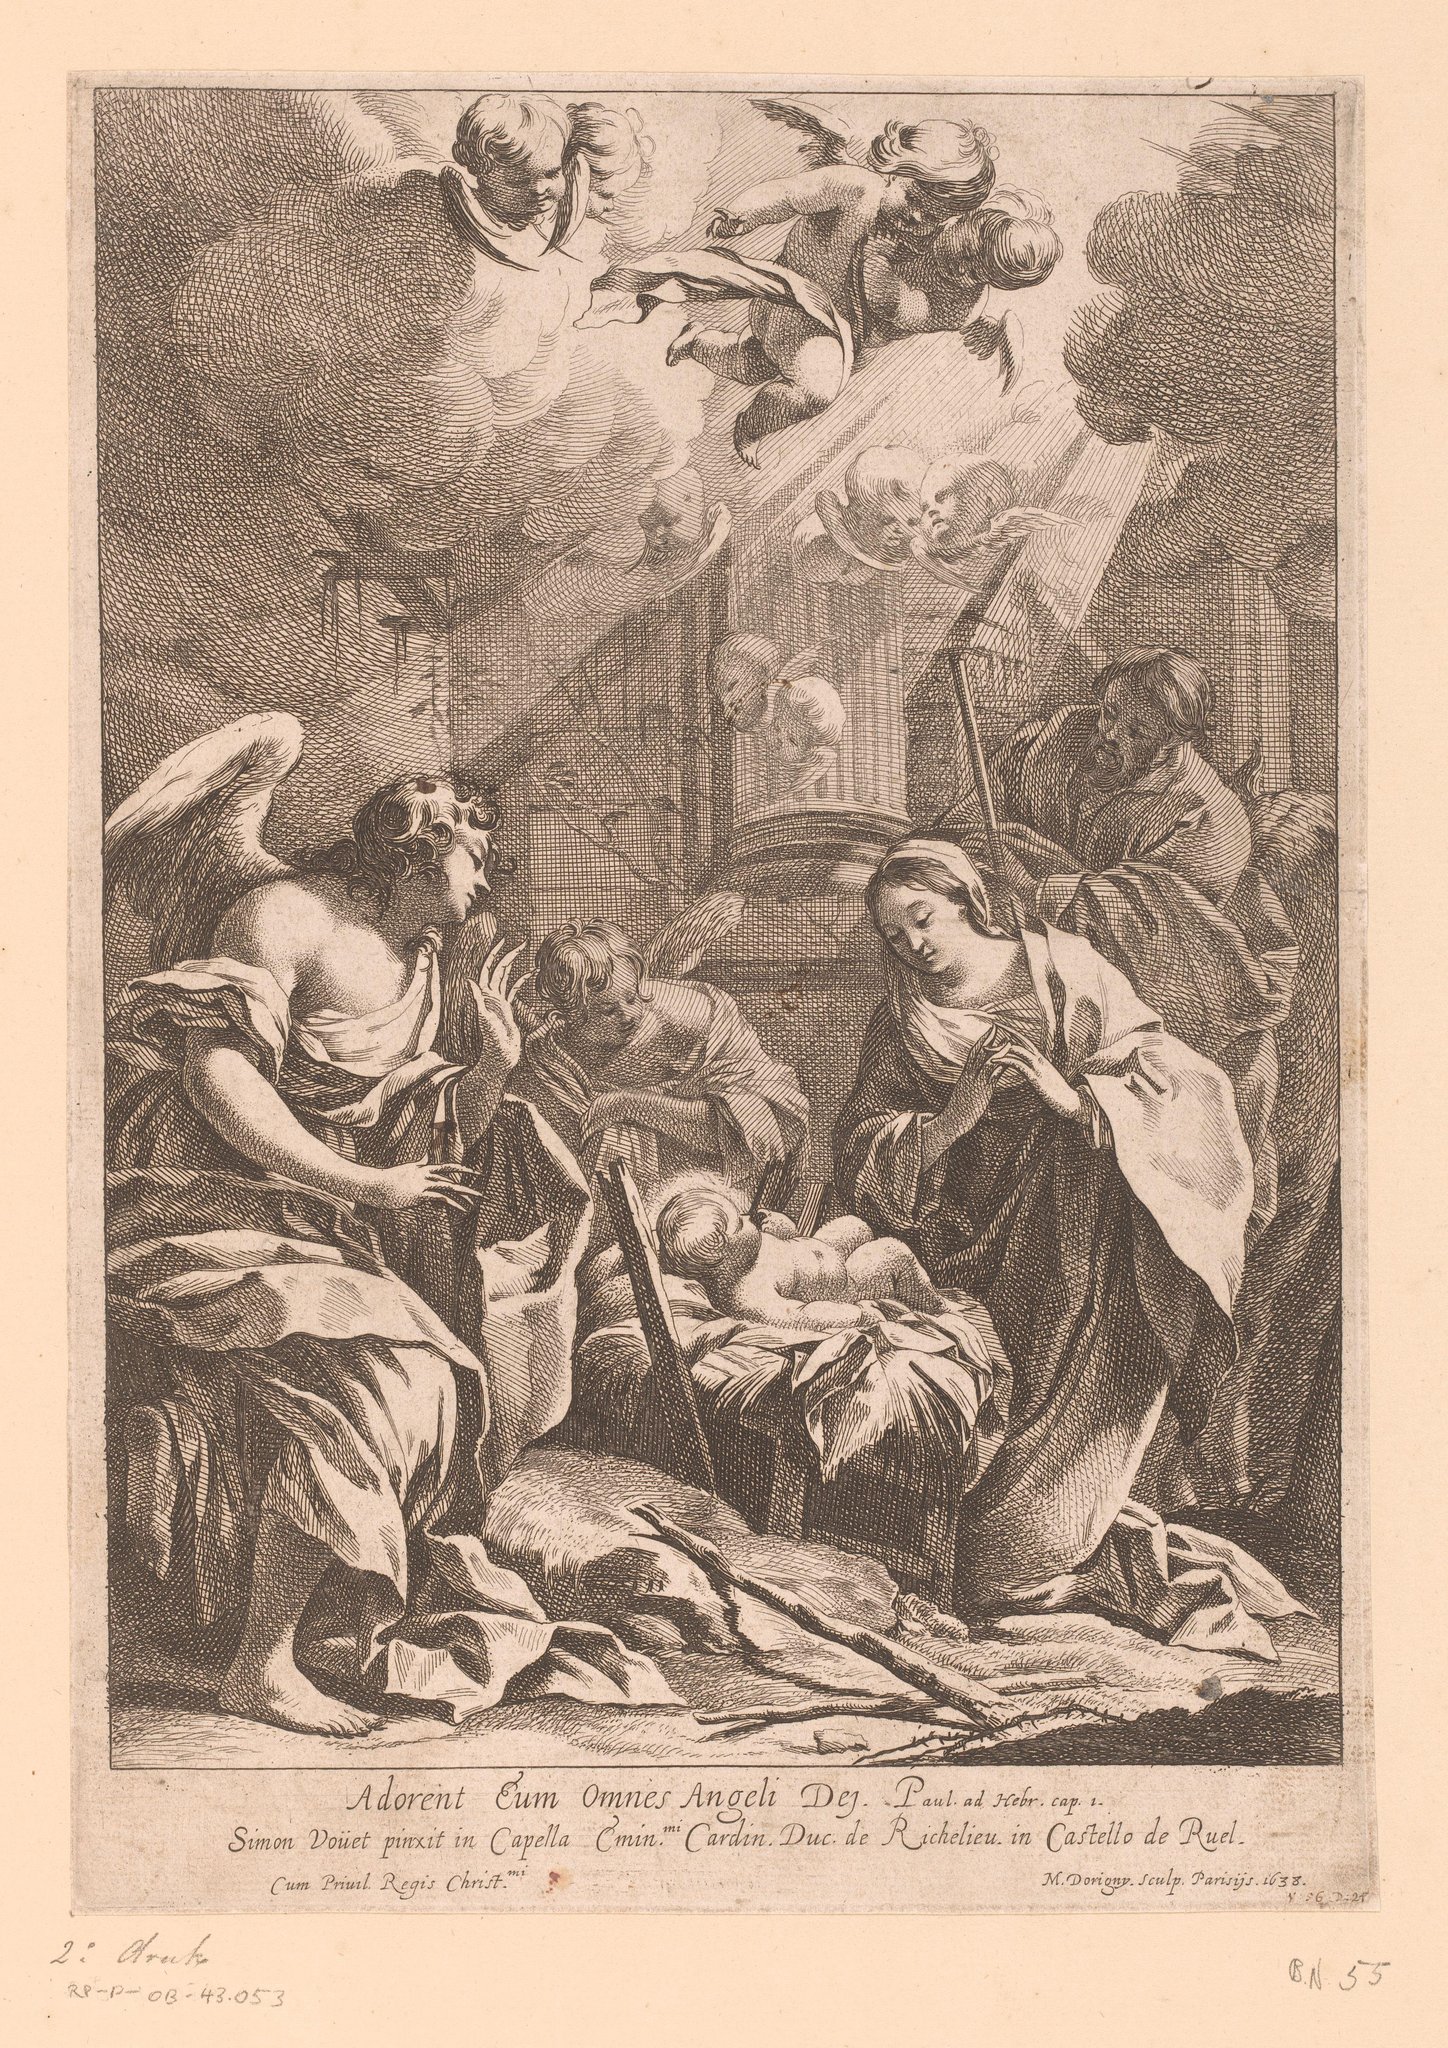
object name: print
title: Geboorte van Christus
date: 1638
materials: paper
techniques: engraving, etching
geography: paris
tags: angels in adoration, mary, joseph and the new-born christ (nativity)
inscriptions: collector's mark: Lugt 240